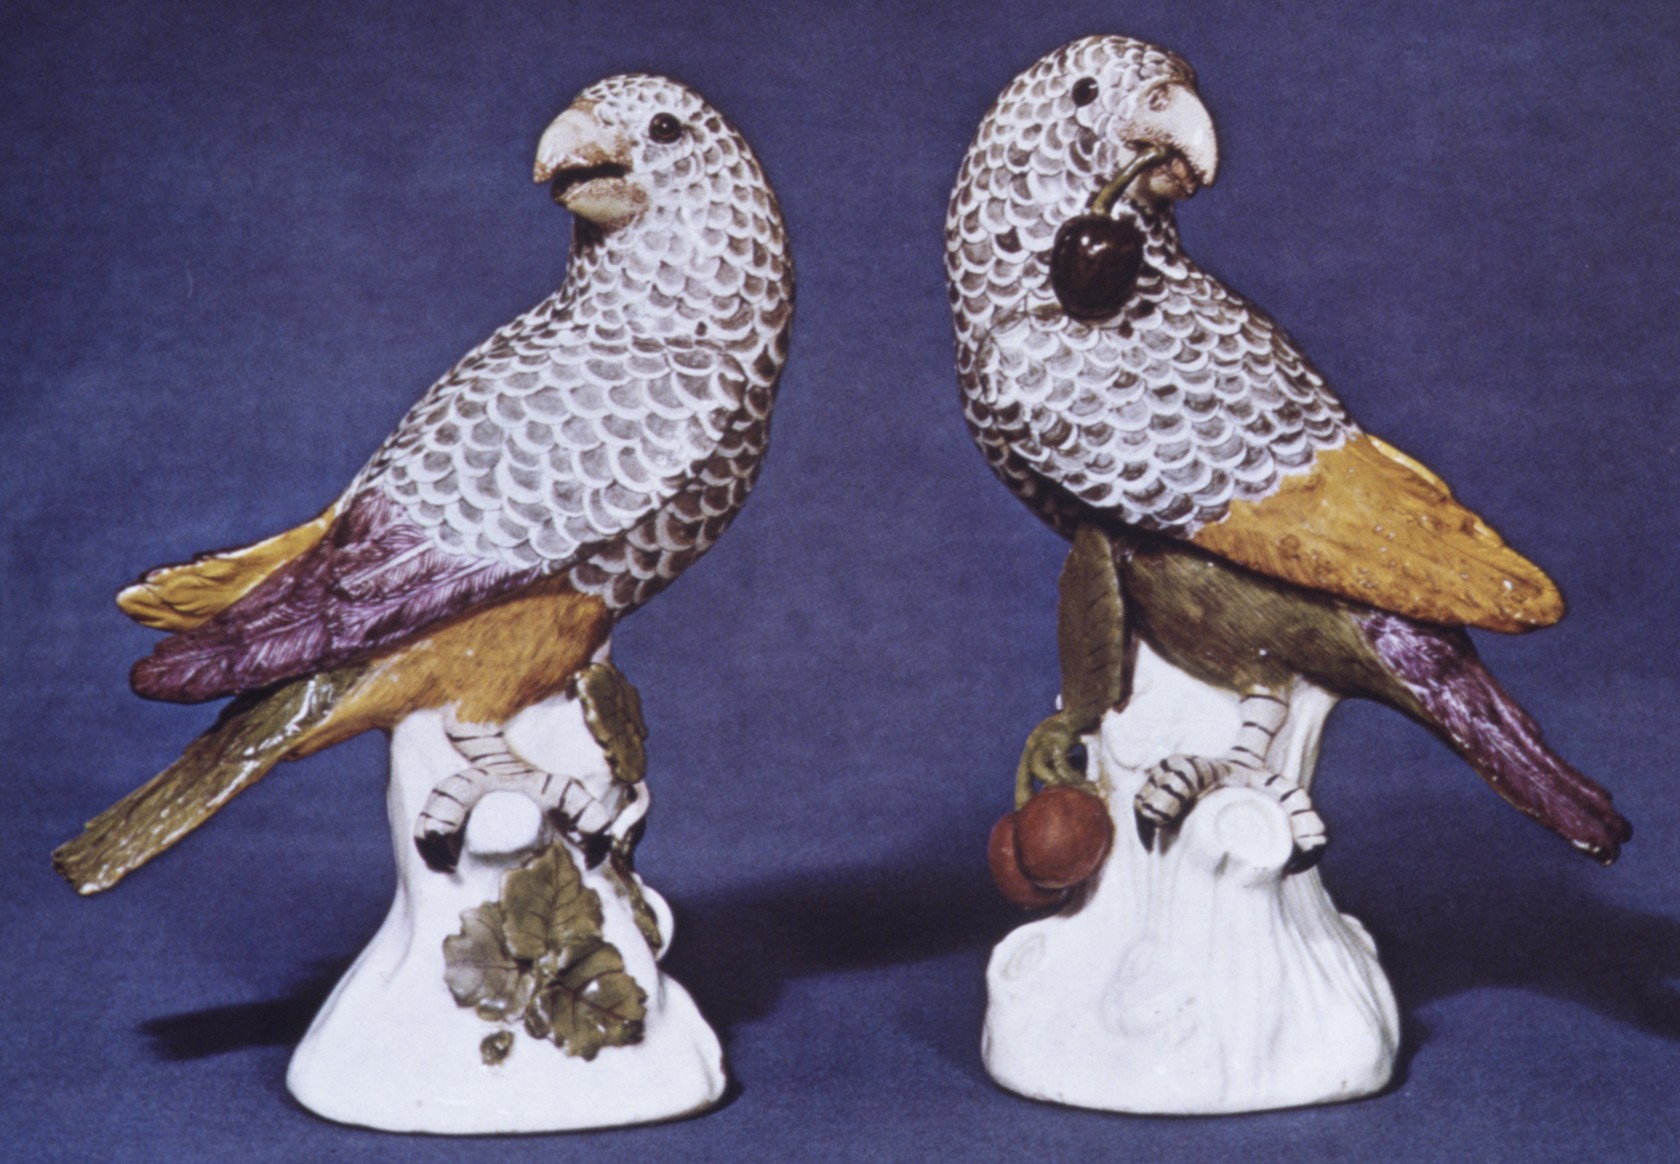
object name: figure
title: Parrot (one of a pair)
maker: meissen manufactory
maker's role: manufactory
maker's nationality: german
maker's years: 1710-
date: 1740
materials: hard paste porcelain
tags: birds,fruit,leaves